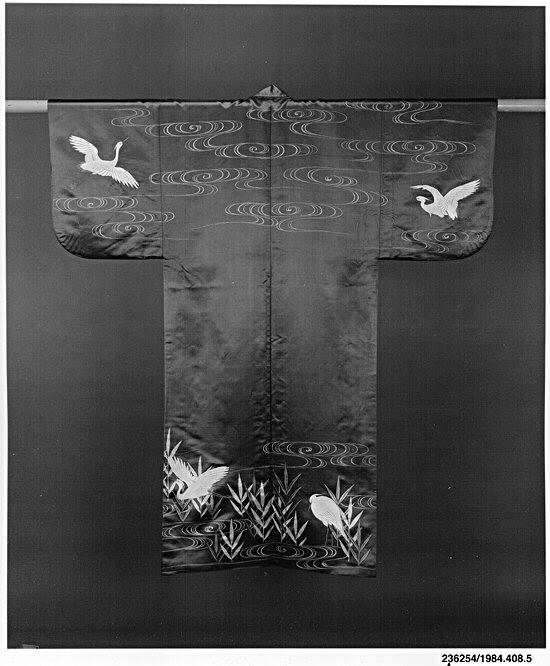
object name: noh robe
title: Noh Costume (Nuihaku) with Egrets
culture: japanese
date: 1868-1912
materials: gold, silk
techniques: embroidery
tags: birds